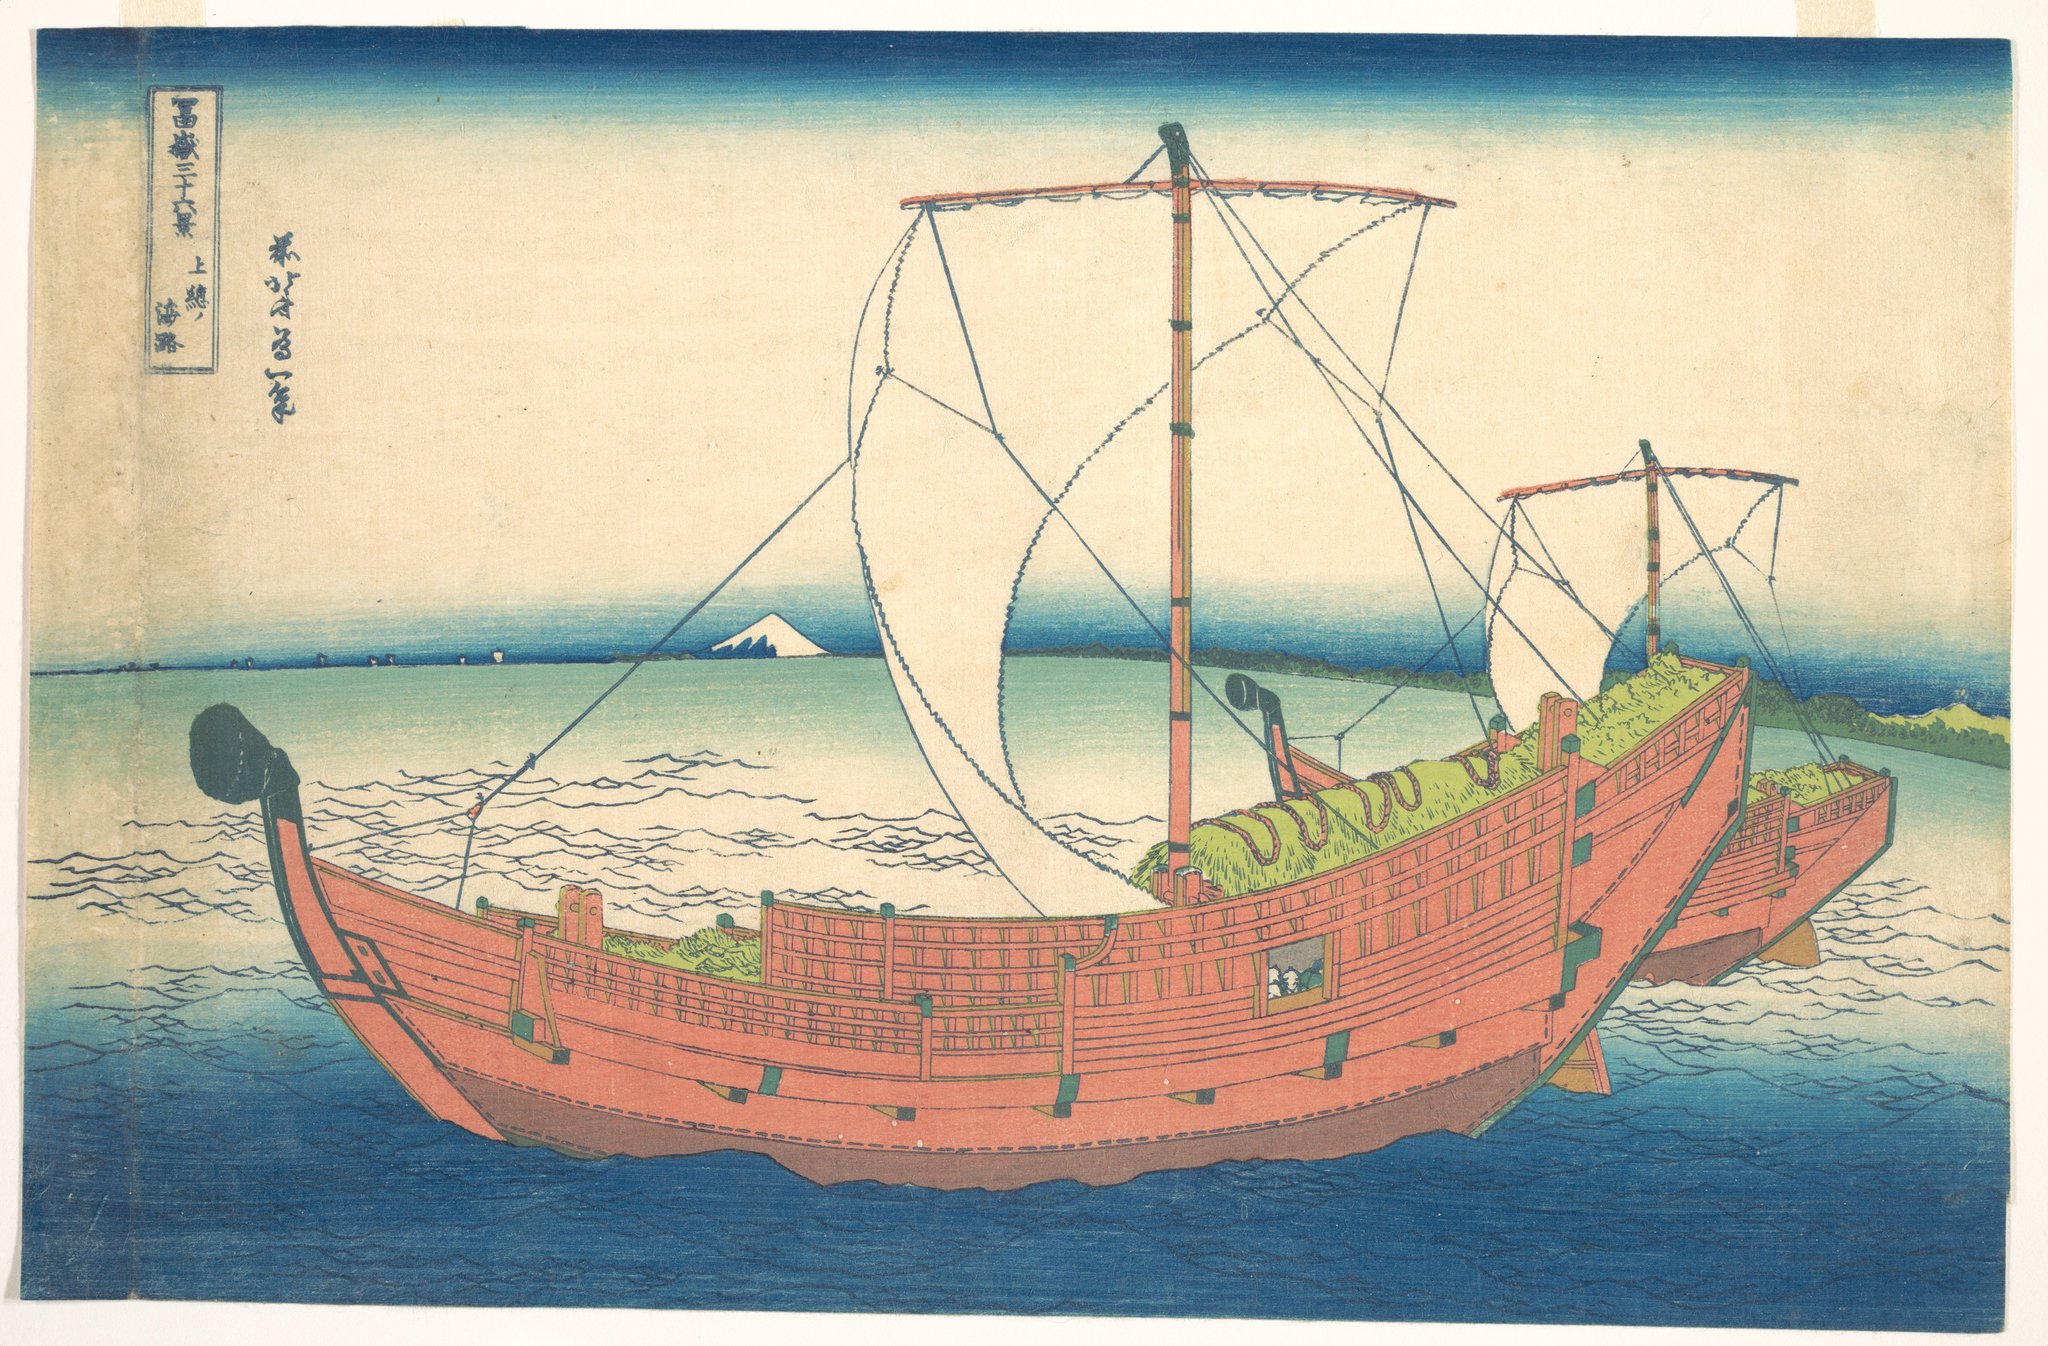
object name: woodblock print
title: At Sea off Kazusa (Kazusa no kairo), from the series Thirty-six Views of Mount Fuji (Fugaku sanjūrokkei)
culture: japanese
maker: katsushika hokusai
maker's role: artist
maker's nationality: japanese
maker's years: 1760-1849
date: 1830-1832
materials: ink, paper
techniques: woodblock print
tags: boats